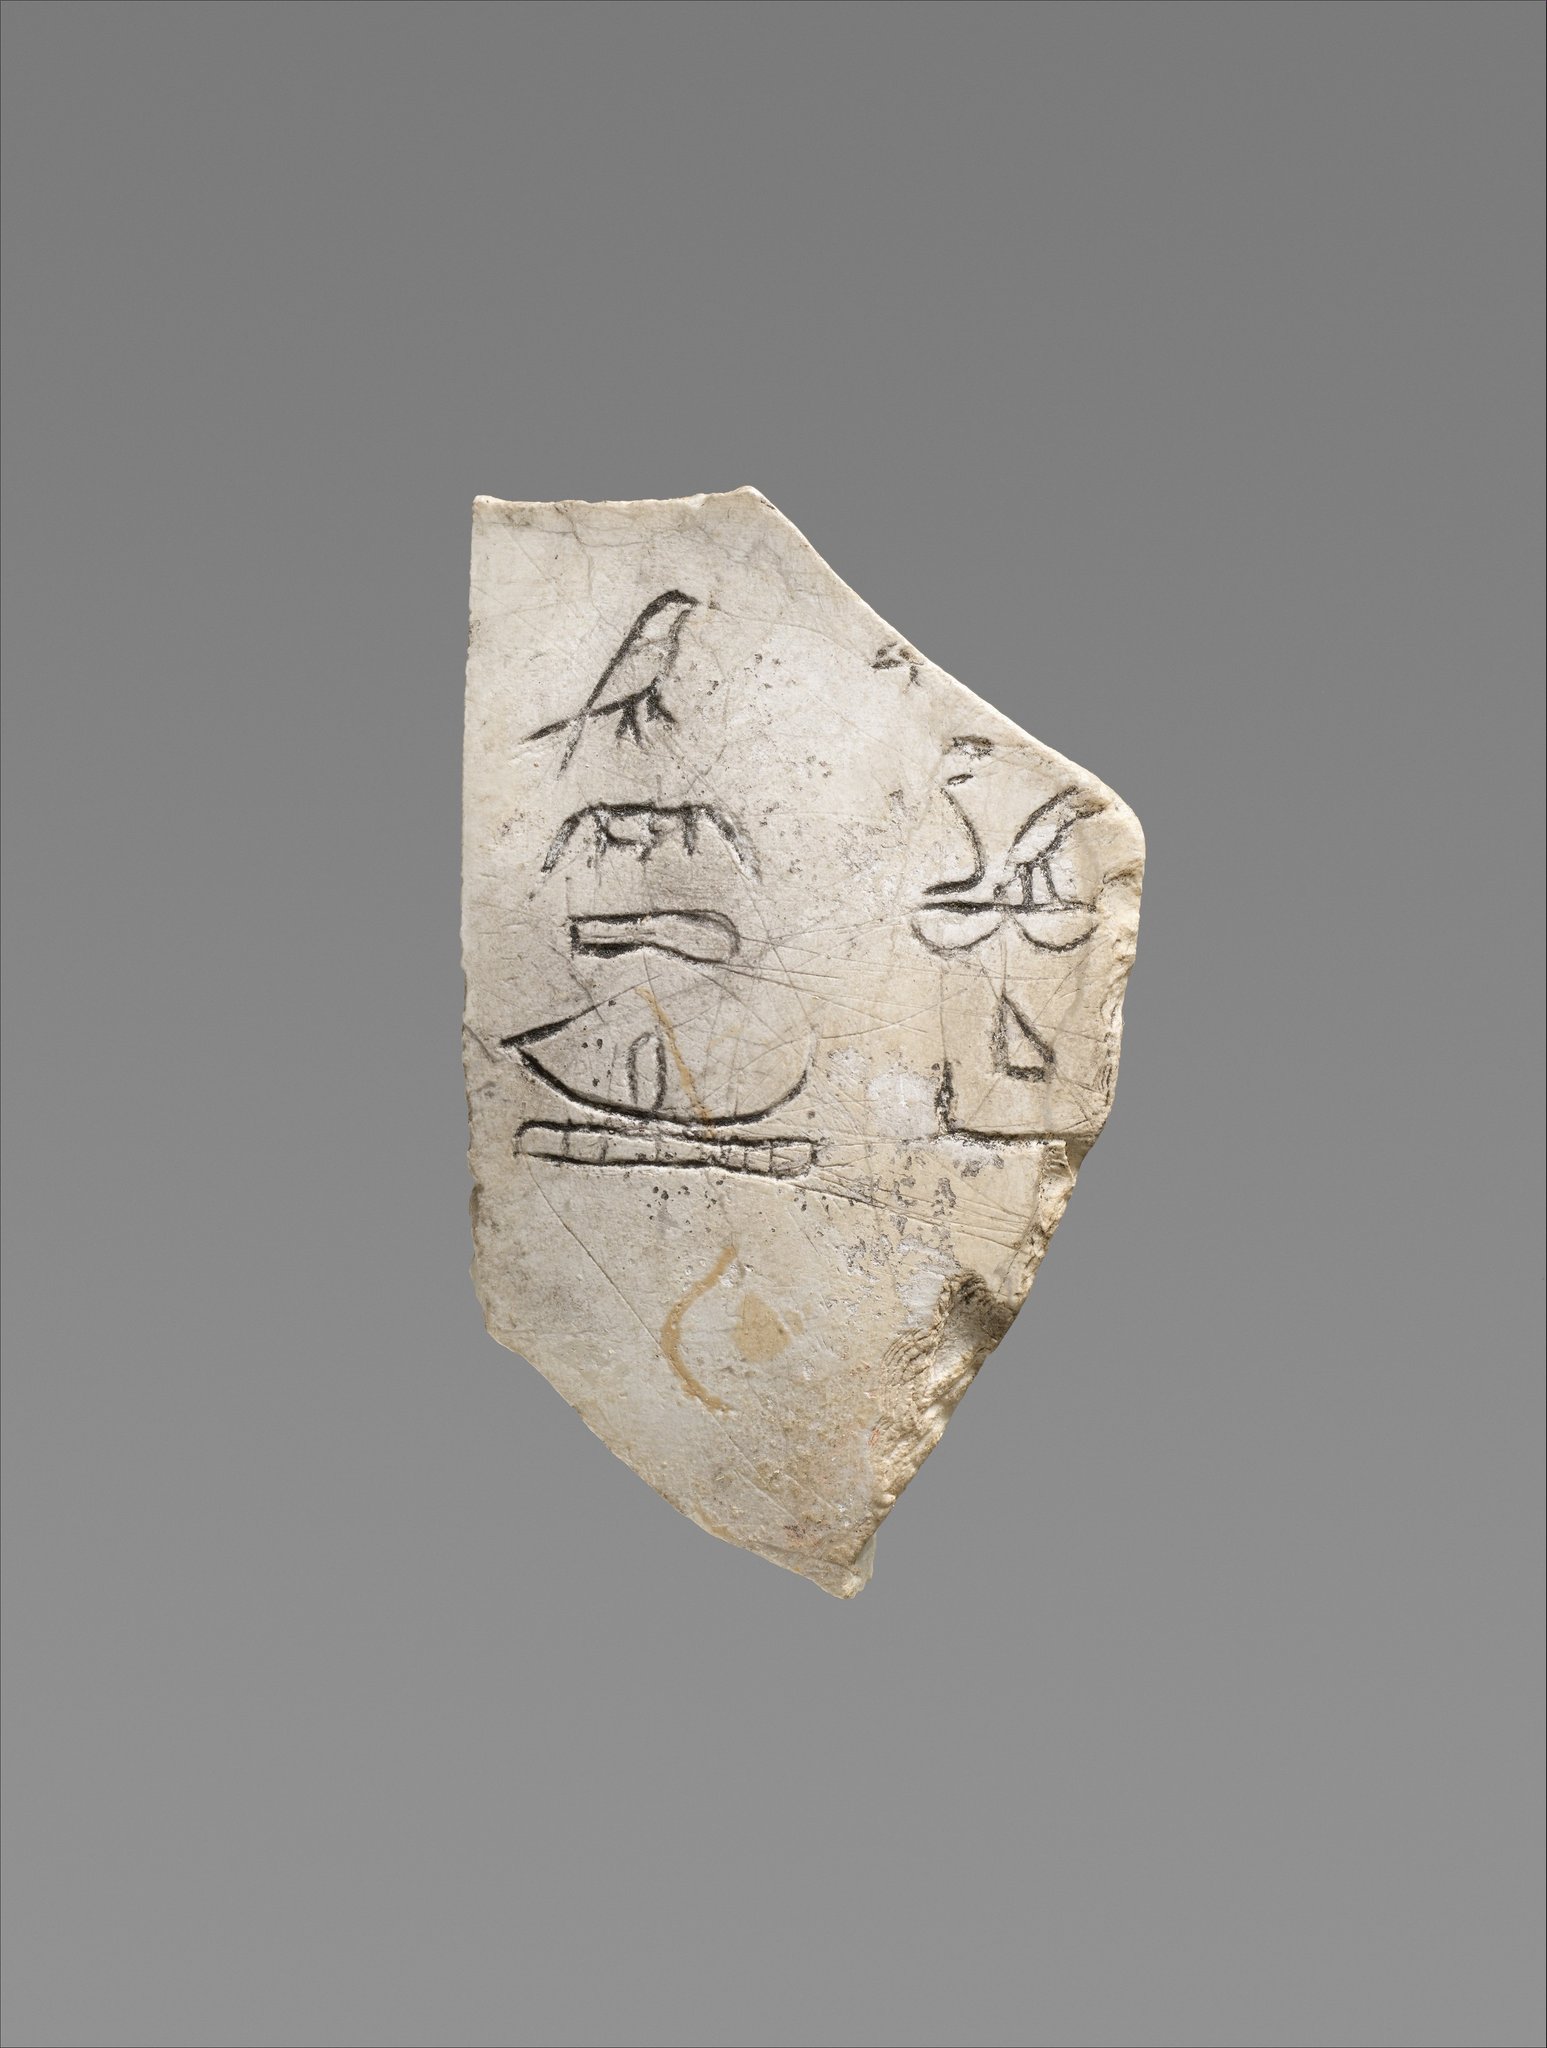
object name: vessel, king qaa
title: Vessel inscribed for King Qaa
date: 2900 BCE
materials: limestone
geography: egypt